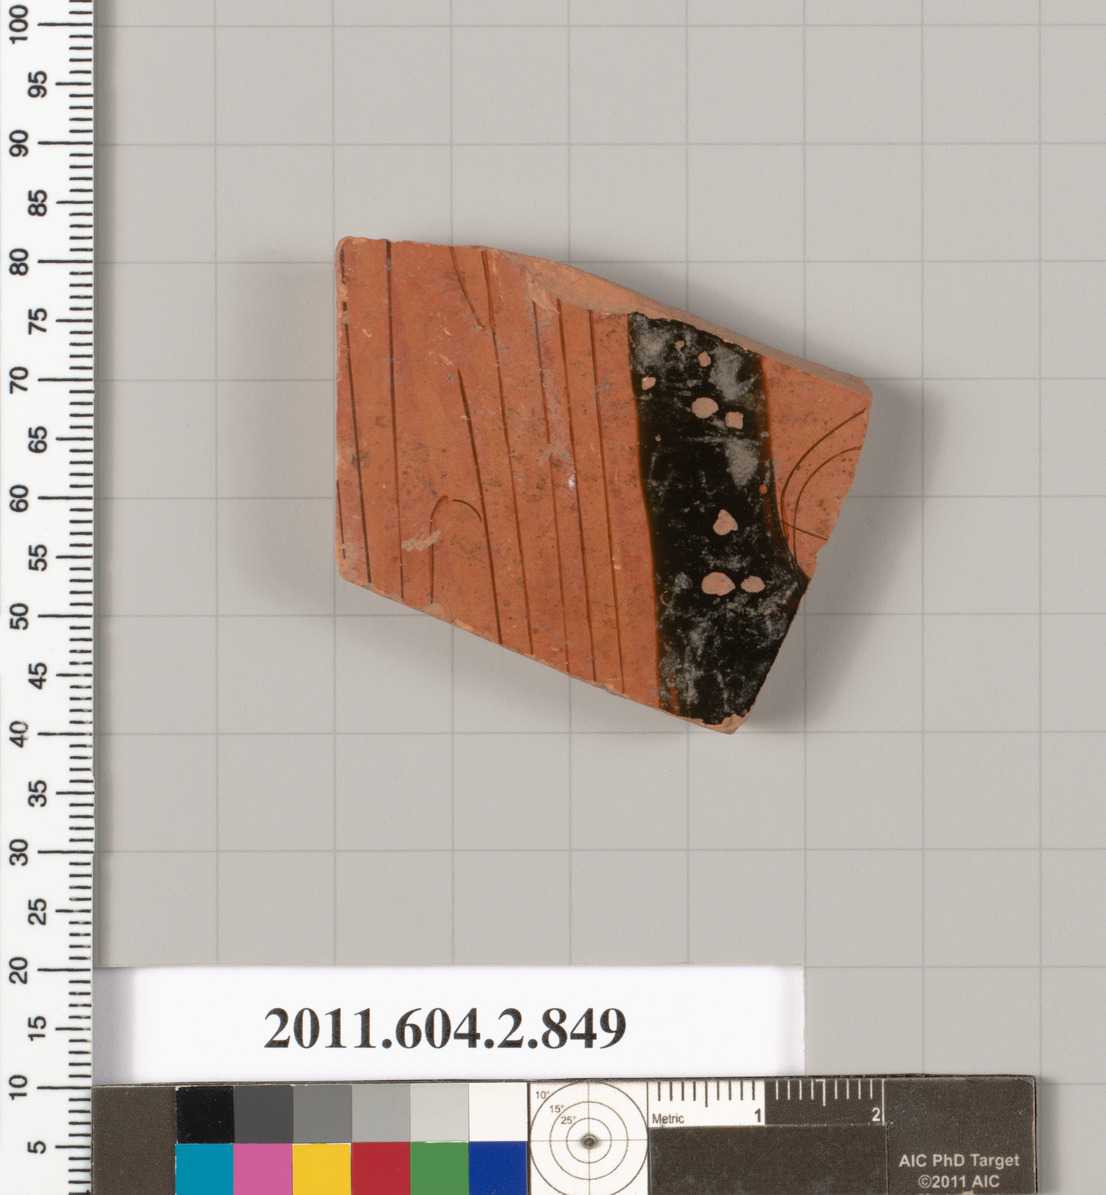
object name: bell krater fragment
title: Terracotta fragment of a bell-krater (bowl for mixing wine and water)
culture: greek, attic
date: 450-440 BCE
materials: terracotta